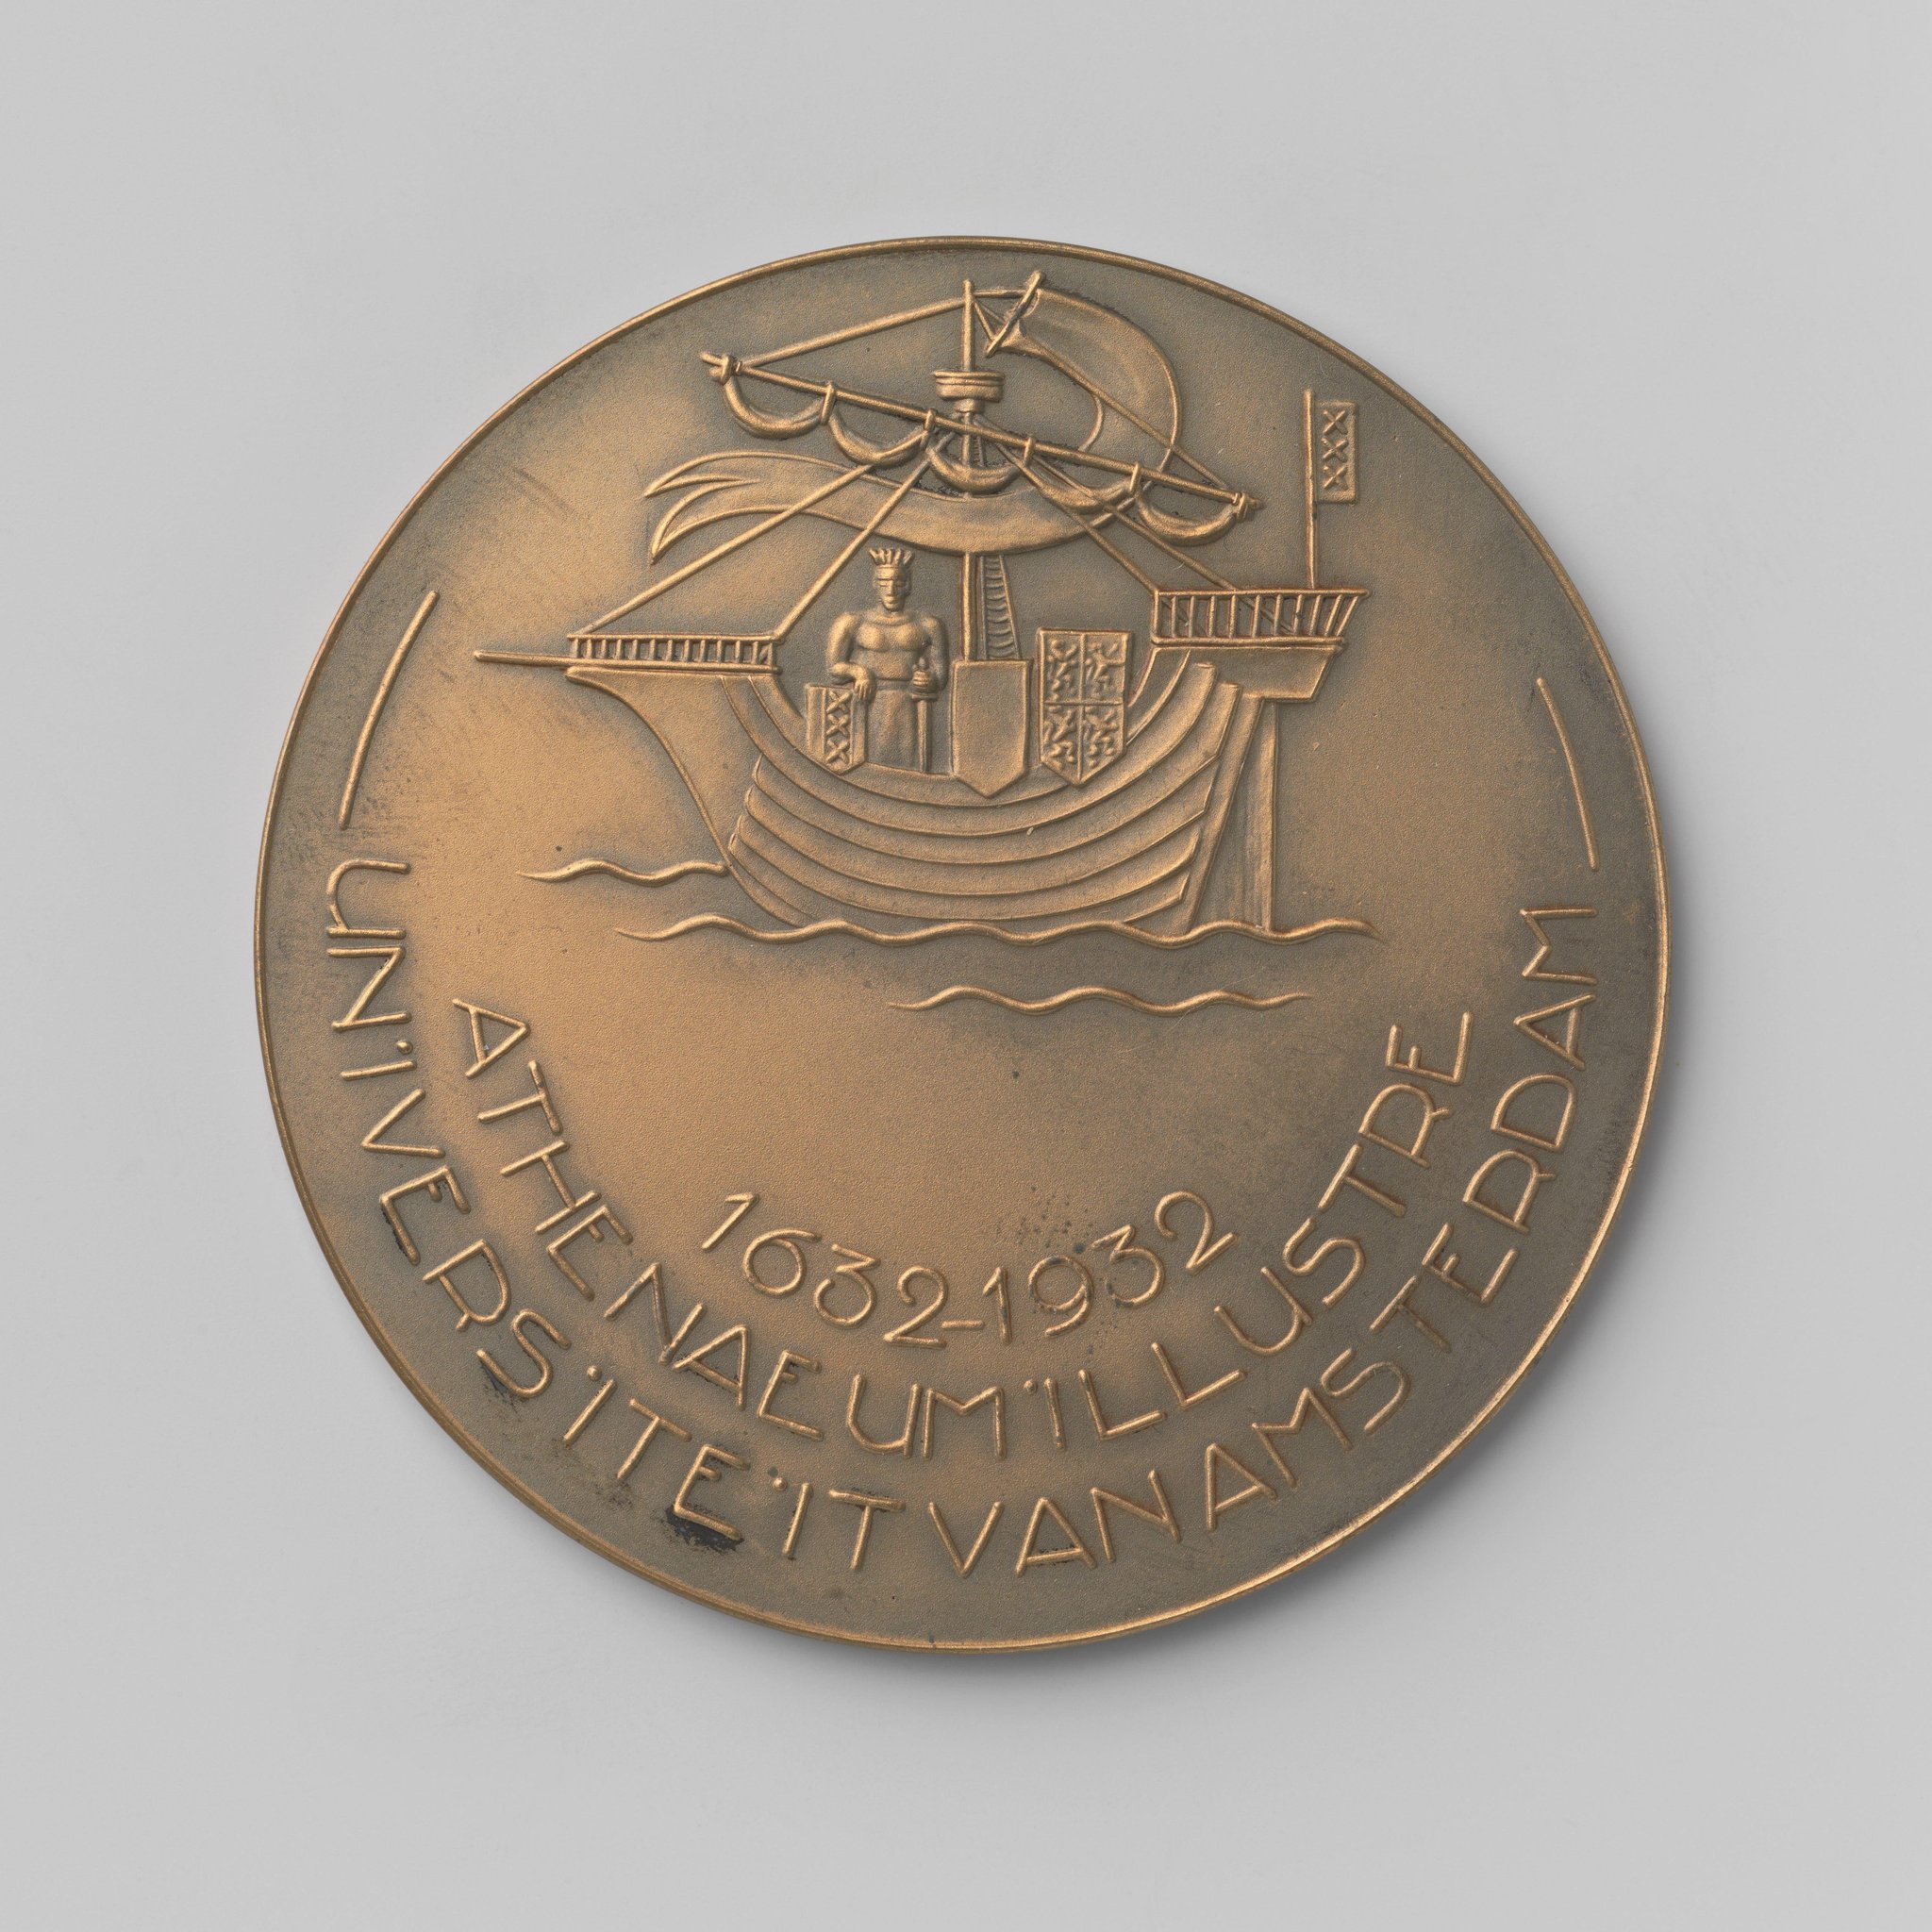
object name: history medal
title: Driehonderdjarig herdenking van de oprichting van het Athenaeum Illustre te Amsterdam 1932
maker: hildo krop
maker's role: draughtsman, print maker, sculptor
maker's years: 1884-1970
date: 1932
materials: bronze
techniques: striking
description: Bronzen penning, op de voorzijde een koggeschip naar links met Amsterdamse vlaggen boven drie regels tekst, op de keerzijde drie mannen met toortsen, met omschrift, boven zes cirkels met de symbolen van faculteiten.